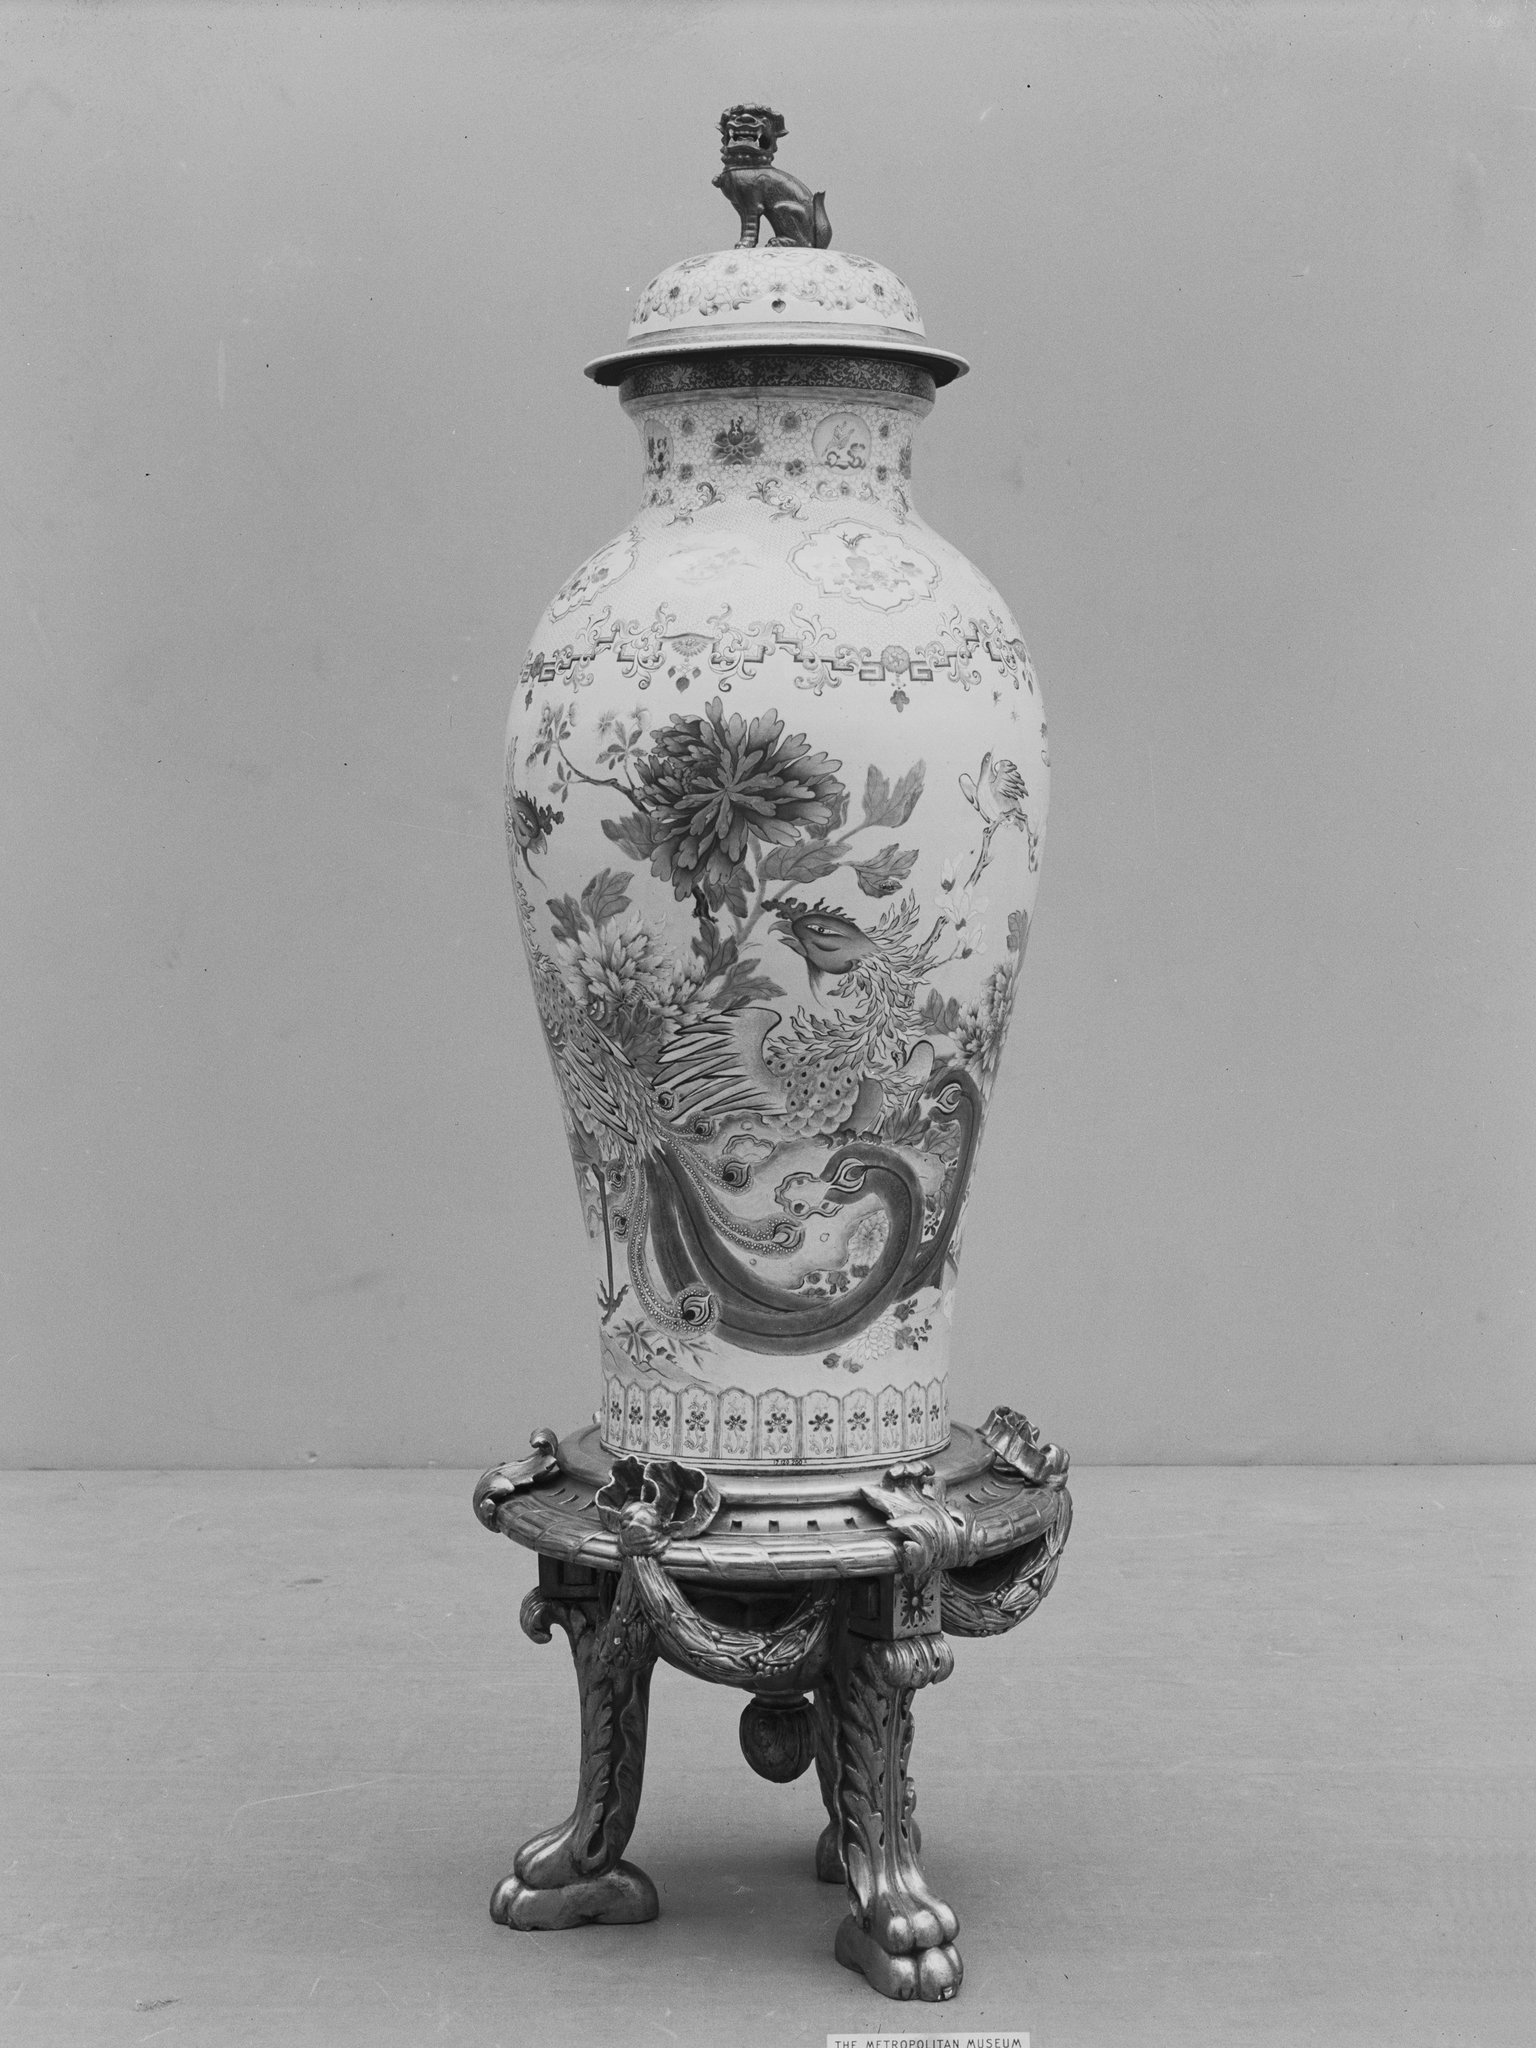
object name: covered jar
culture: chinese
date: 1736-1795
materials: enamel, porcelain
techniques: overglaze, painting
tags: animals,flowers